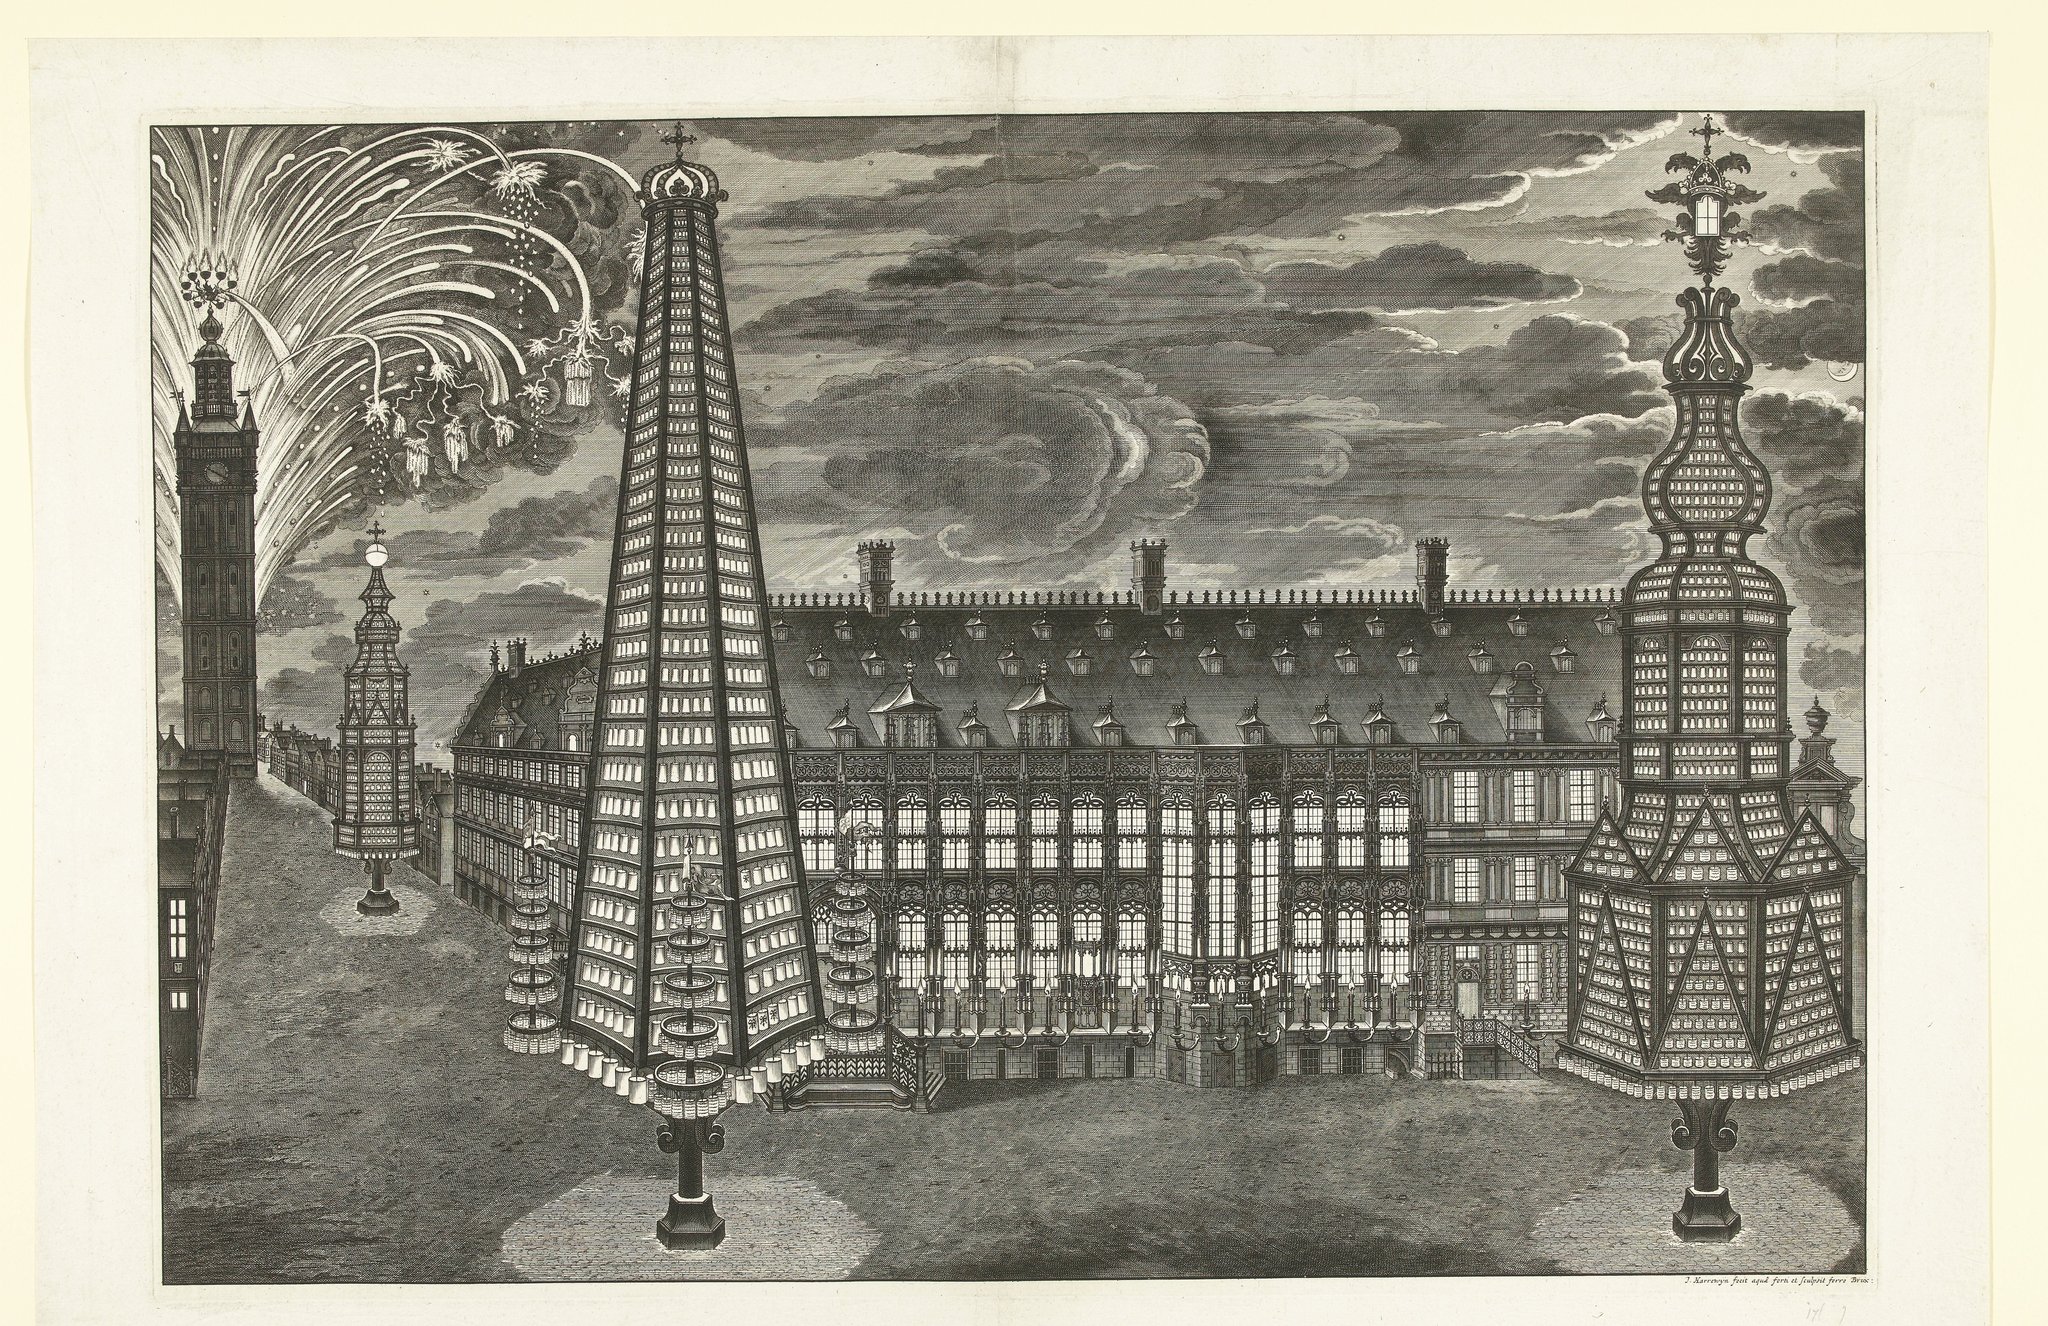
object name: print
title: Illuminatie en vuurwerk te Gent, 1717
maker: jacobus harrewijn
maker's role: print maker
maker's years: 1660-1740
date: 1717-1719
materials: paper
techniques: etching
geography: brussels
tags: vienna, charles vi (holy roman emperor), bonfire, fire-works (+ illumination, fire-works ~ festive activities)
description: Gebruikt als illustratie in: Relation de l'inauguration solemnelle de sa Sacrée Majesté Impériale et Catholique Charles VI ... celebrée à Gand ... le 18 Oct. 1717, Gent 1719. Deze staat van de prent vóór de titel: "Représentation de la cérémonie solennelle de l'Inauguration de sa Majesté Impériale et Catholique Charles VI Empereur des Romains et III du nom Roy des Espagnes, célébrée au Grand Théâtre dressé sur la Place du Vendredy en la Ville de Gand, Capitale de la Province le 18 octobre 1717". Deze prent is door Muller eerst onjuist beschreven onder FMH 2222B als een voorstelling van de illuminatie en vuurwerk te Gent ter ere van de troonsbestijging van de Spaanse koning Karel II, december 1665.